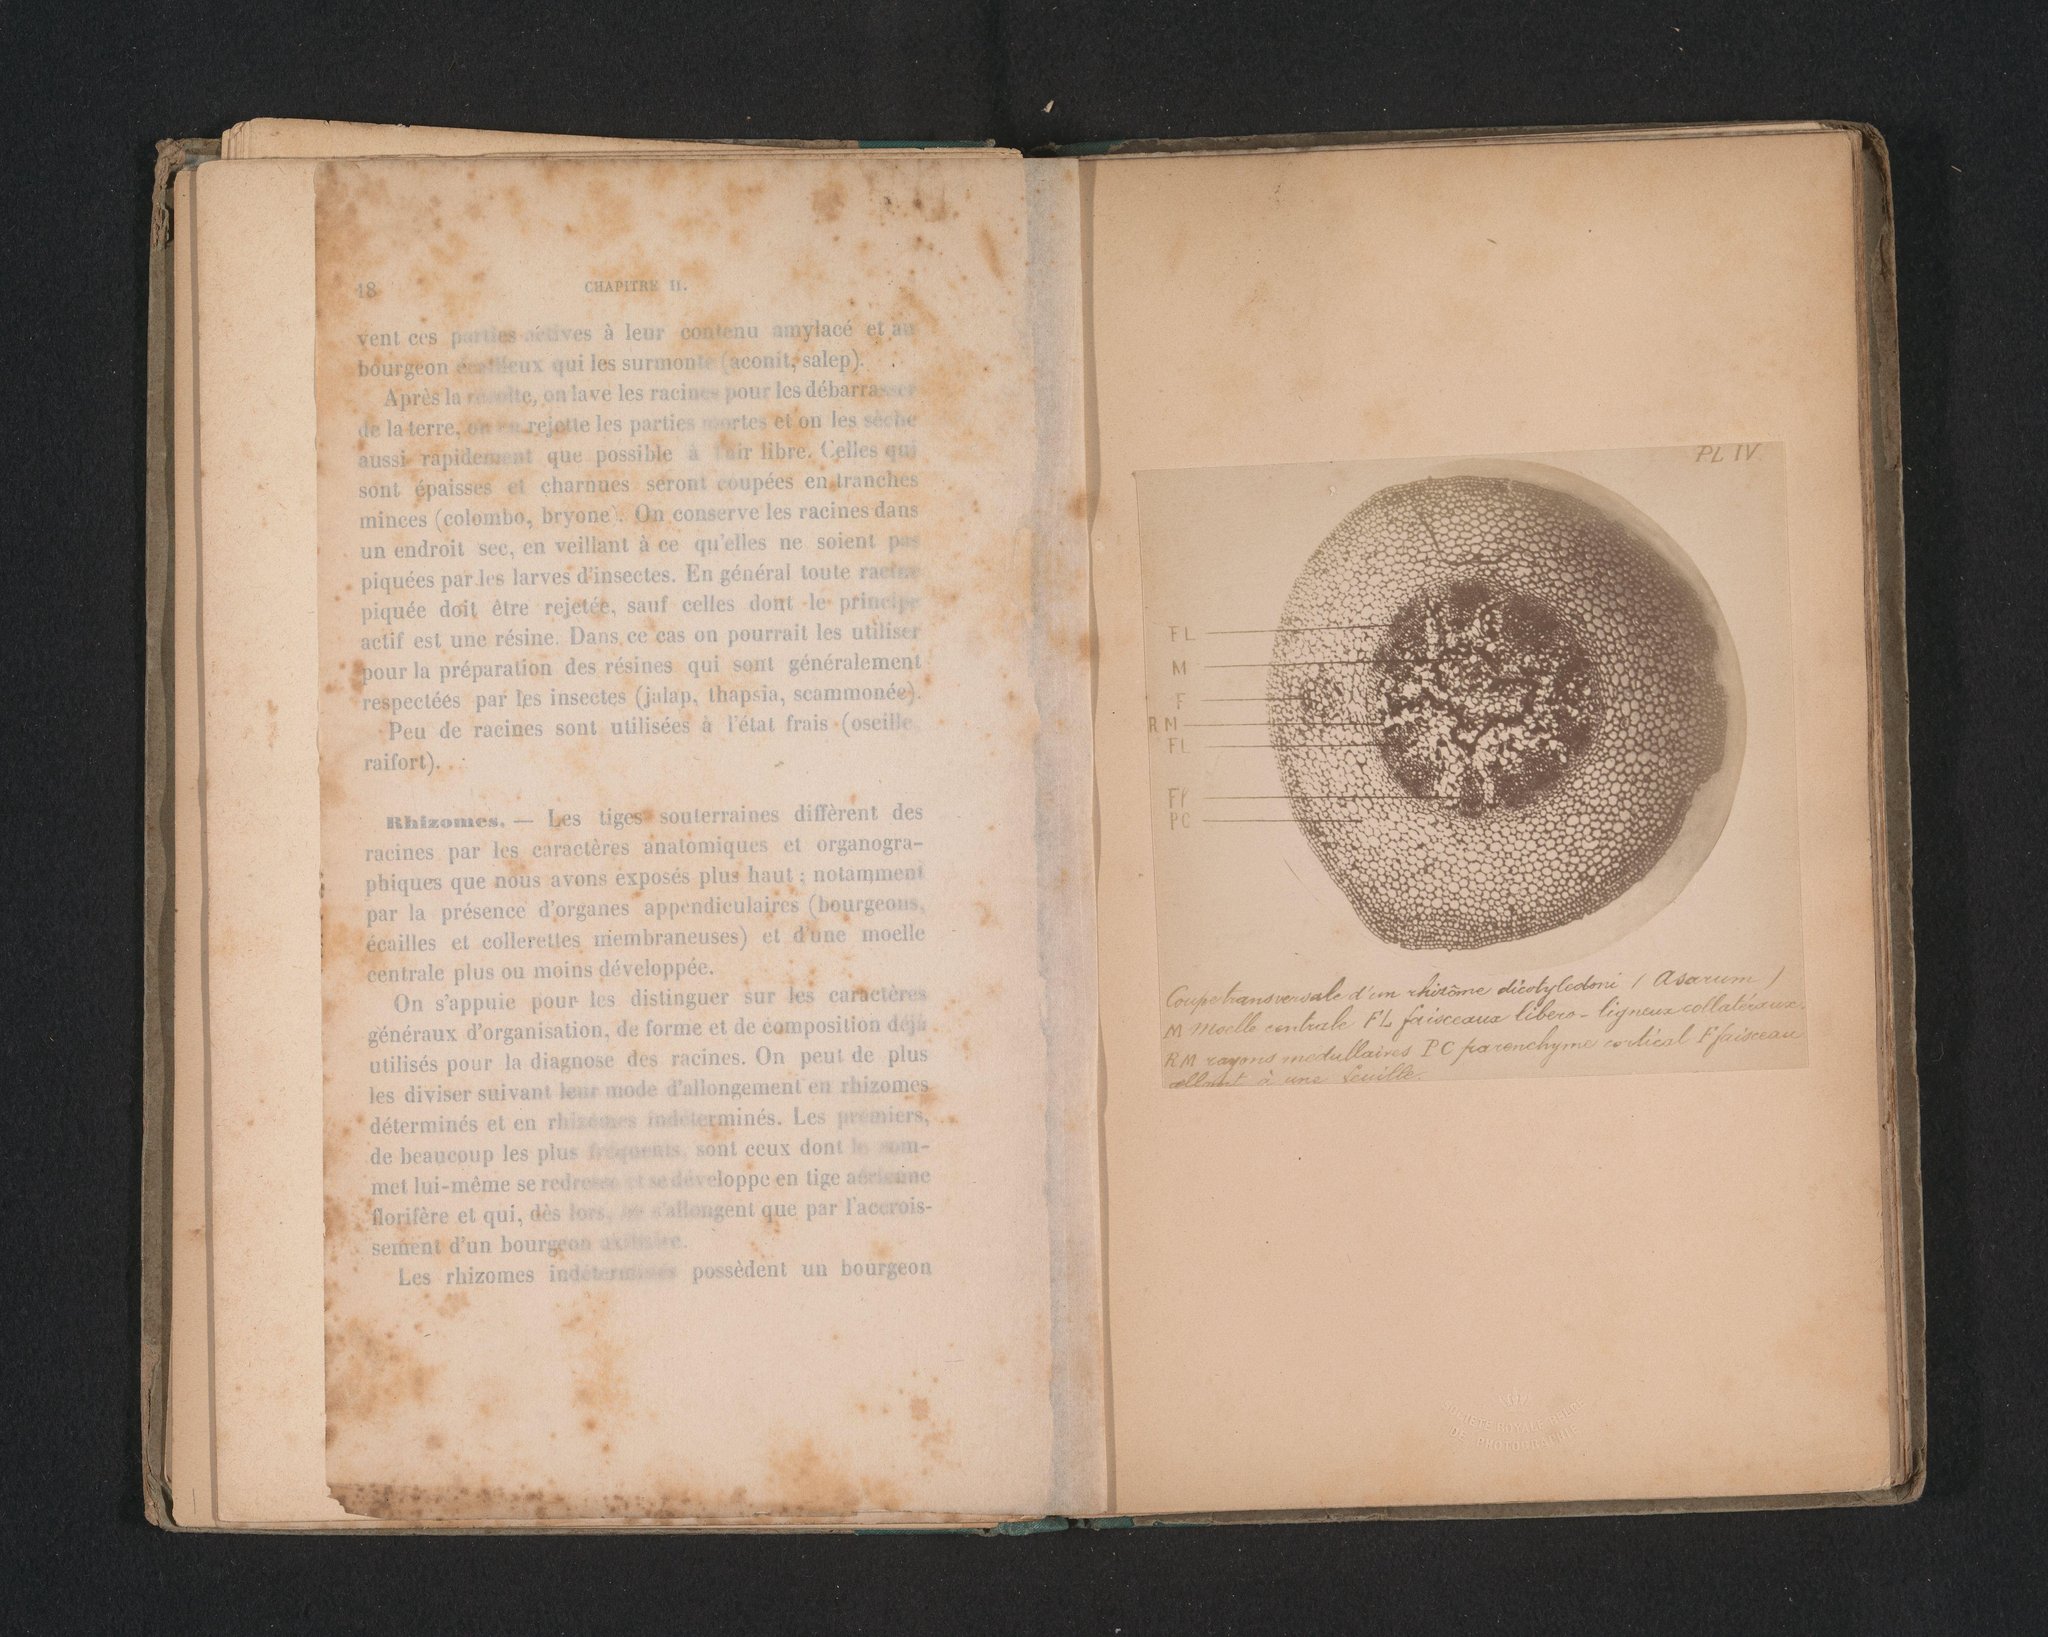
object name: page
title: Dwarsdoorsnede van wortels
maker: Anonymous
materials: photographic support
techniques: albumen print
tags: plants; vegetation